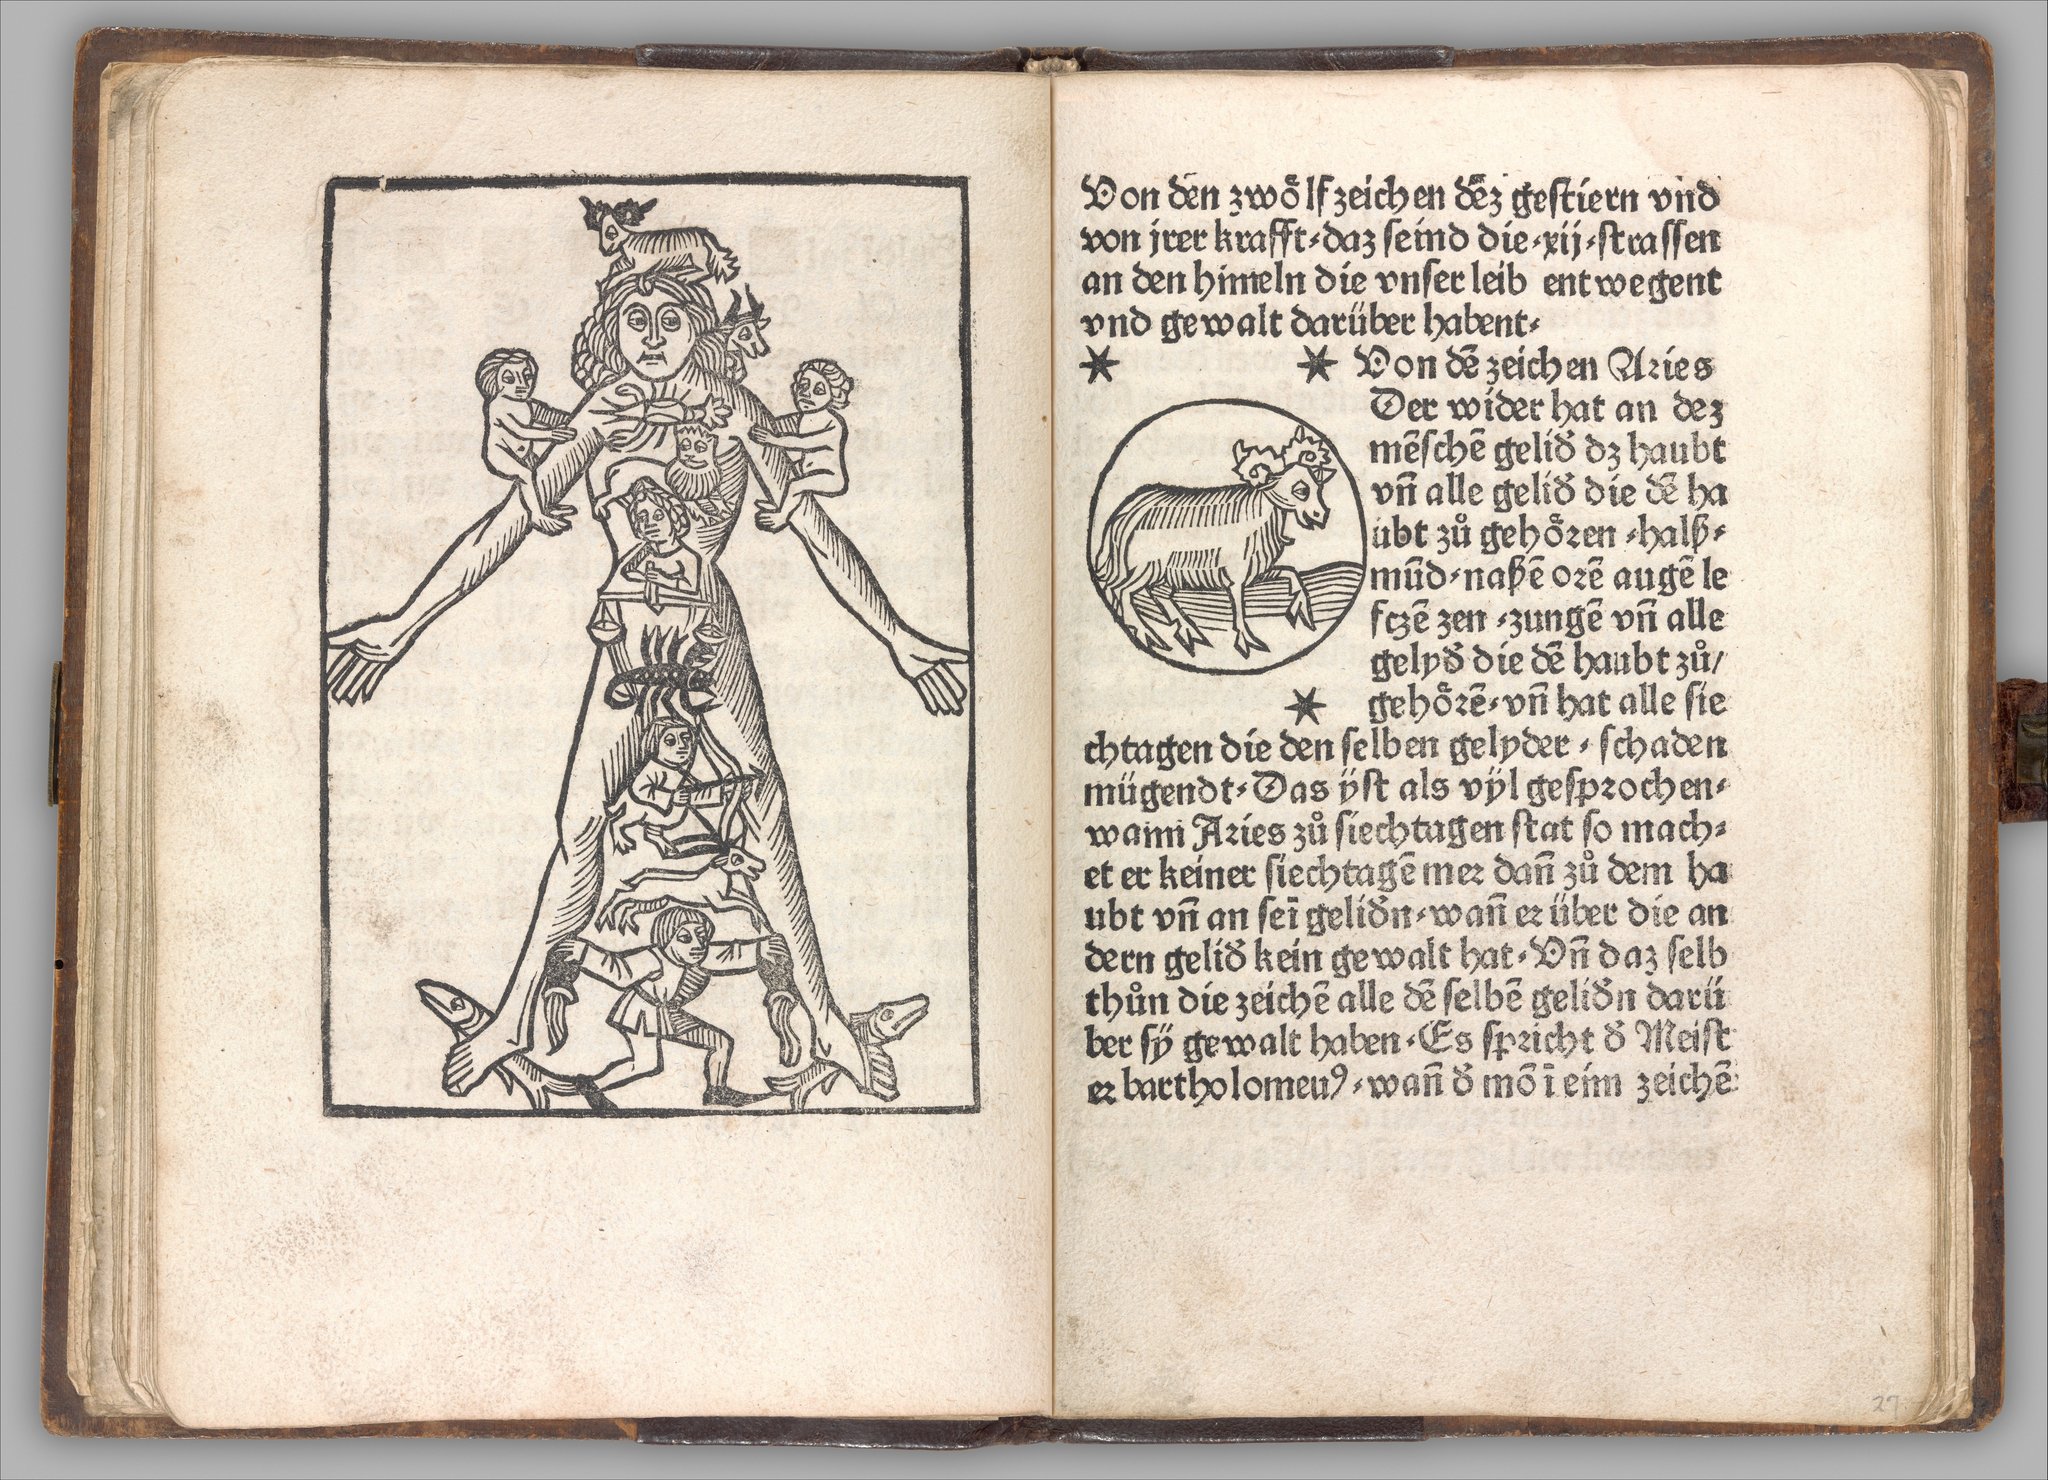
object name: book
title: German Almanac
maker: hans schönsperger the elder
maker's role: publisher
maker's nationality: german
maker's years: 1481-1520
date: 1484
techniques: woodcut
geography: germany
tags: animals,infants,women